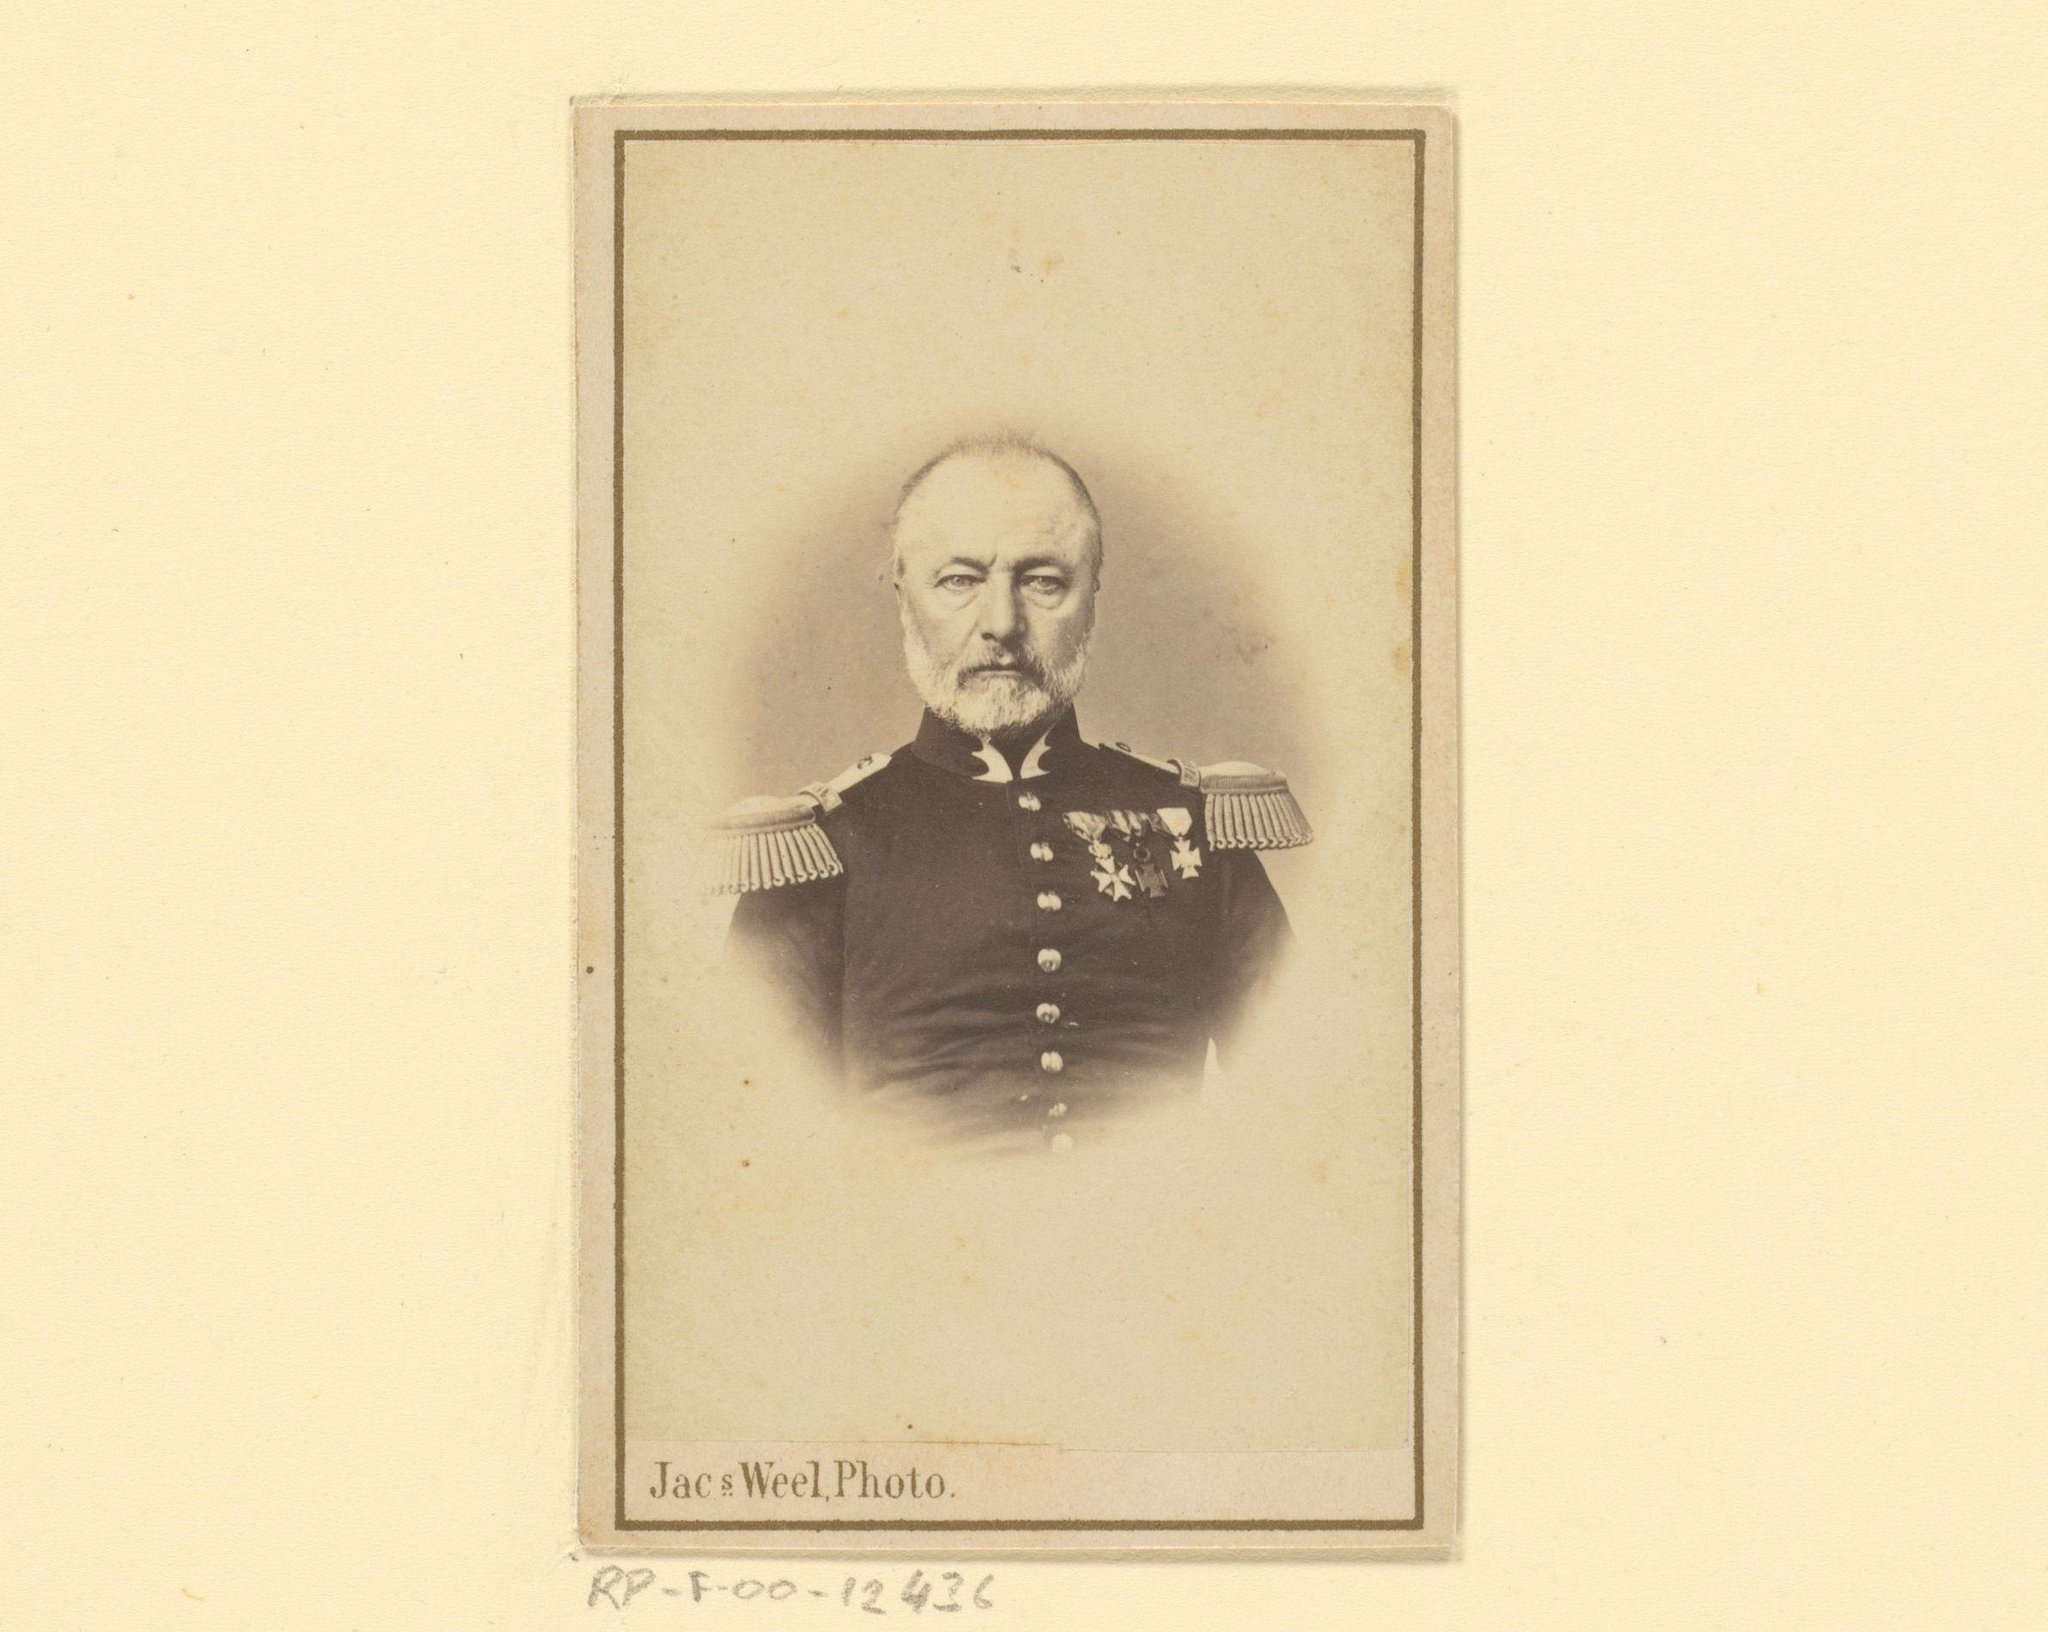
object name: carte de visite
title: Portret van L.A. Witte Eechout, luitenant van de infanterie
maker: jacobus weel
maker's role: fotograaf, lithograaf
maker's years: 1837-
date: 1855-1868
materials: cardboard, paper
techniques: albumen print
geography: utrecht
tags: the hague, nijmegen, historical persons, (military) uniforms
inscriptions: inscription: ‘Jacs Weel,/ Photographe./ Nieuwe brug./ Utrecht./ Adres Lijnmarkt, No 60.’, signature: ‘Witte Eechout’